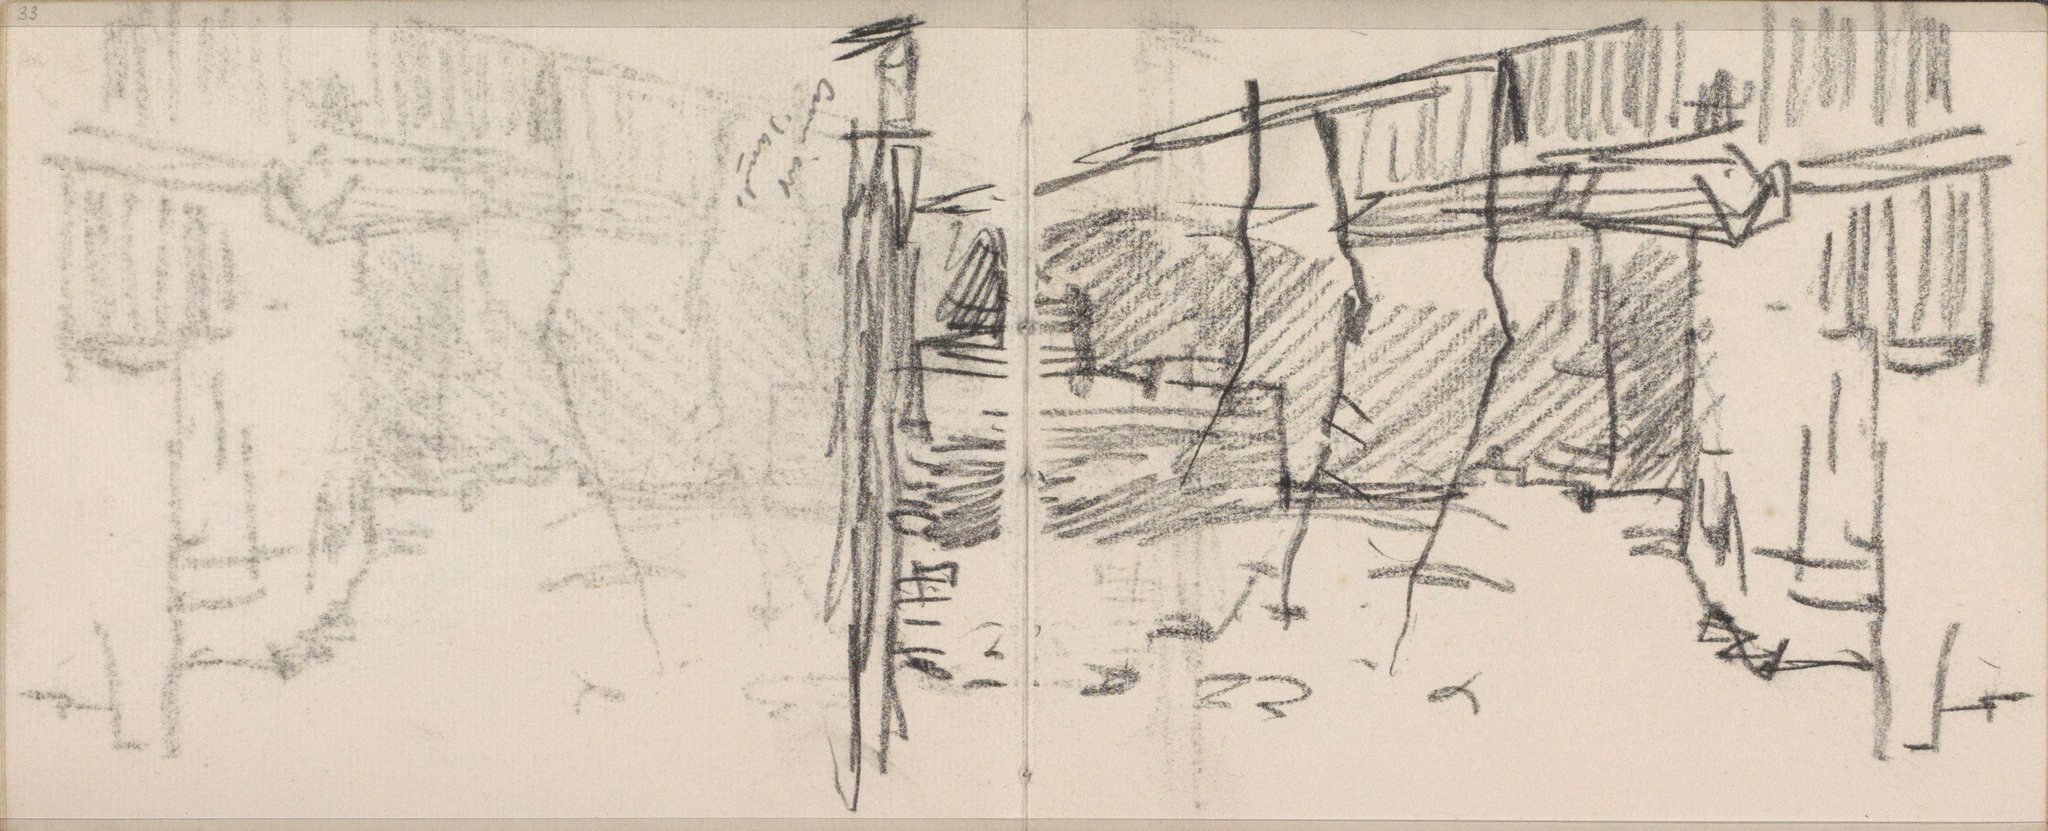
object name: sketchbook leaf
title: Gezicht op de Lauriergracht te Amsterdam bij avond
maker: george hendrik breitner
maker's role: draughtsman, painter, print maker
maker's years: 1857-1923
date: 1886-1891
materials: chalk, paper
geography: amsterdam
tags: urban housing, canals, waters (in city)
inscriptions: annotation: ‘Lauriergr/ 's avonds’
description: Pagina 33 en pagina 34 uit een schetsboek met 32 bladen.